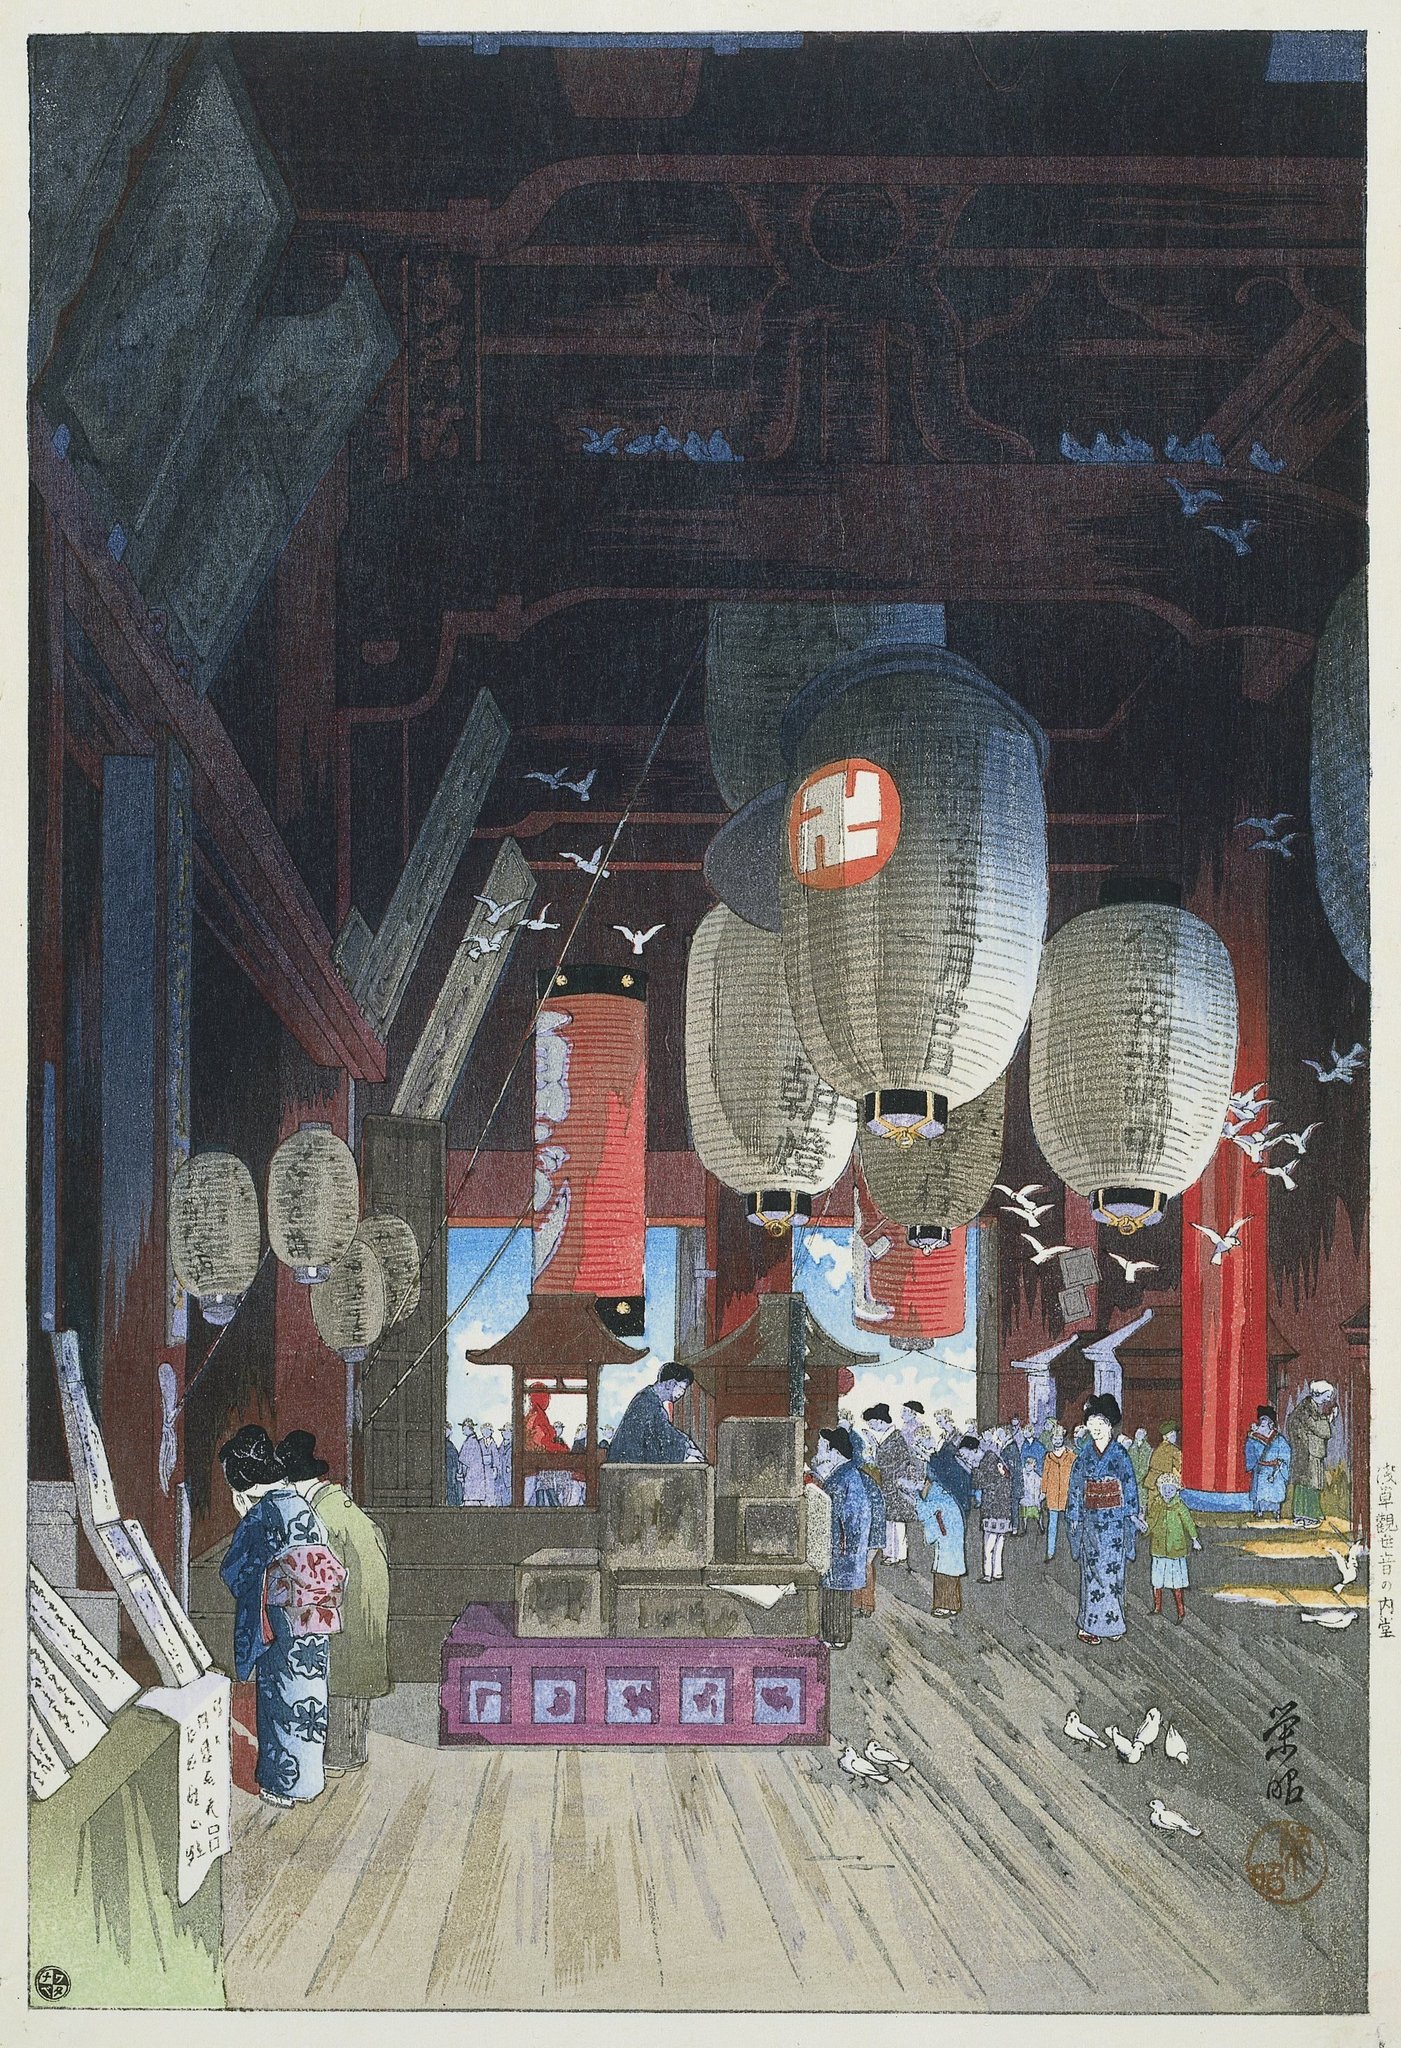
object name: print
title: In de Kannon tempel in Asakusa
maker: watanabe shōzaburō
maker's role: publisher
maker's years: 1885-1962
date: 1932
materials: paper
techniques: woodcut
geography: japan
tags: temple, shrine ~ non-christian religions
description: Interieur van de houten Kannon tempel in Asakusa met bezoekers, duiven en aan het plafond grote lampions.